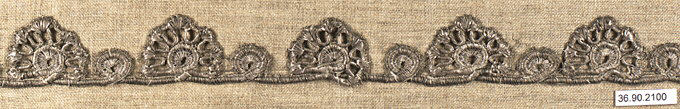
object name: piece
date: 1801-1900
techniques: lace